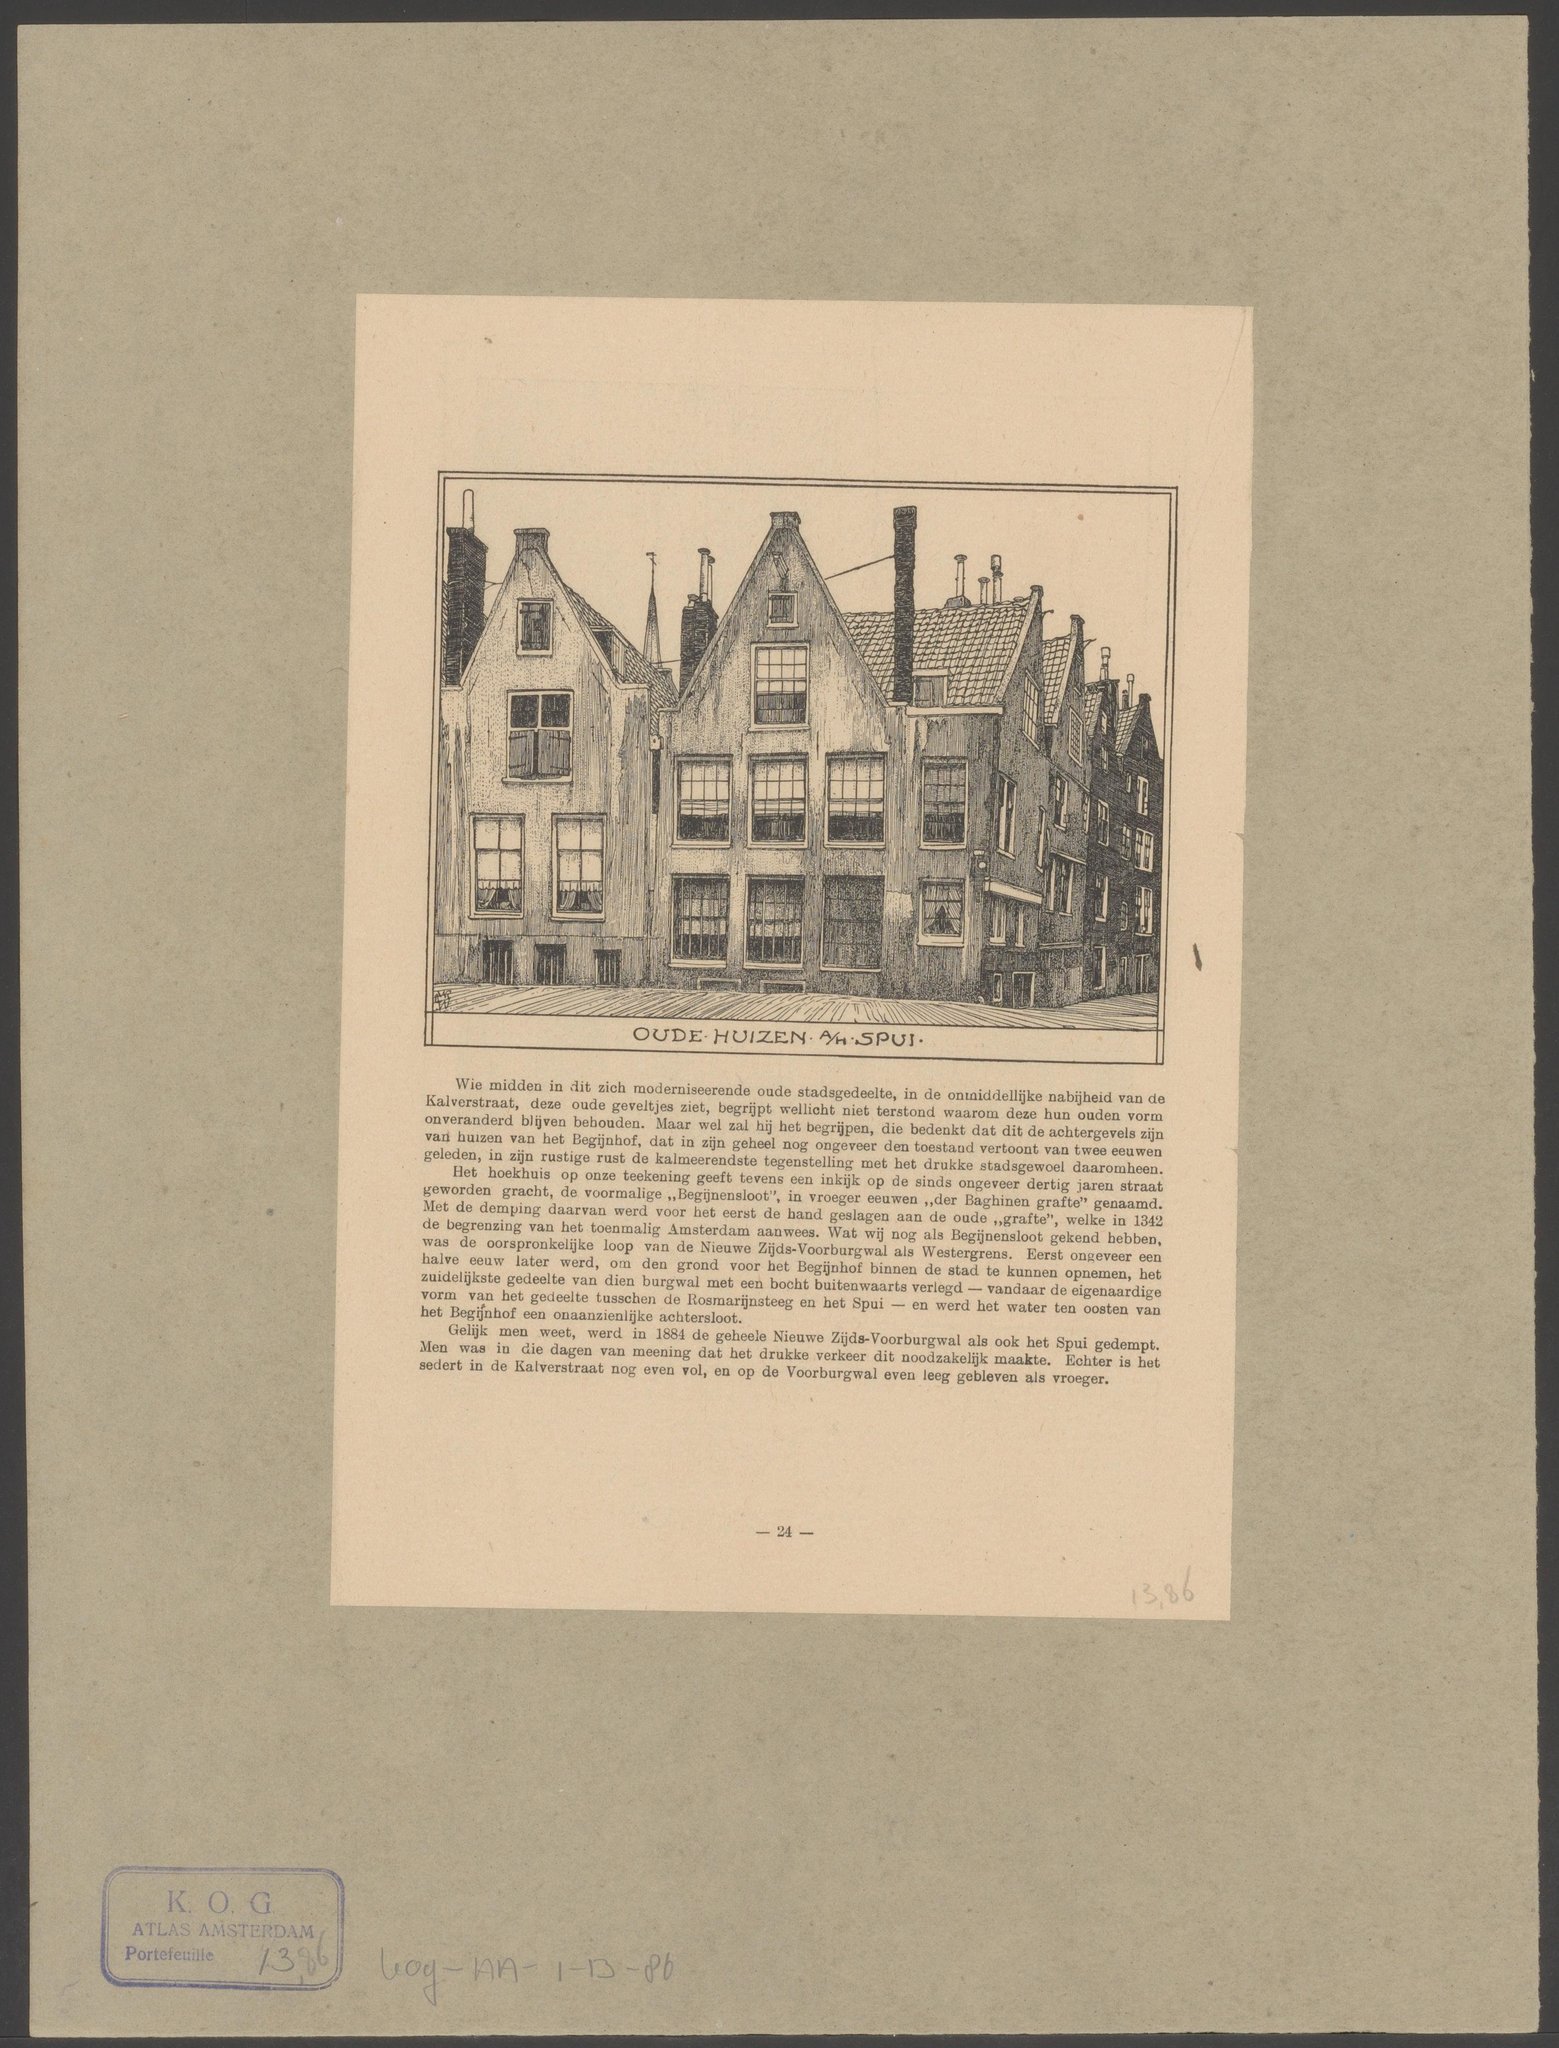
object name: photomechanical print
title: Oud-Amsterdam 100 Stadsgezichten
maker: willem wenckebach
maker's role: designer, draughtsman, painter, print maker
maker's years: 1860-1937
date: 1870-1923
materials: paper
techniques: letterpress printing, line block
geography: amsterdam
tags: city-view in general; 'veduta', the usual house or row of houses, street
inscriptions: collector's mark: ‘13,86’ Lugt 1641b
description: Onderwerpsrubriek binnen de Atlas Amsterdam: Slatuinenpad, Sloterkade, Slootstraat, Slijkstraat, Snoekjesgracht, Sophiapark, Spaarndammerdijk, Spiegelgracht, Spinhuissteeg, Spui, Spuistraat (ook lage Erf), Staalstraat, Stadhouderskade, Steenpad, Stroomarkt.